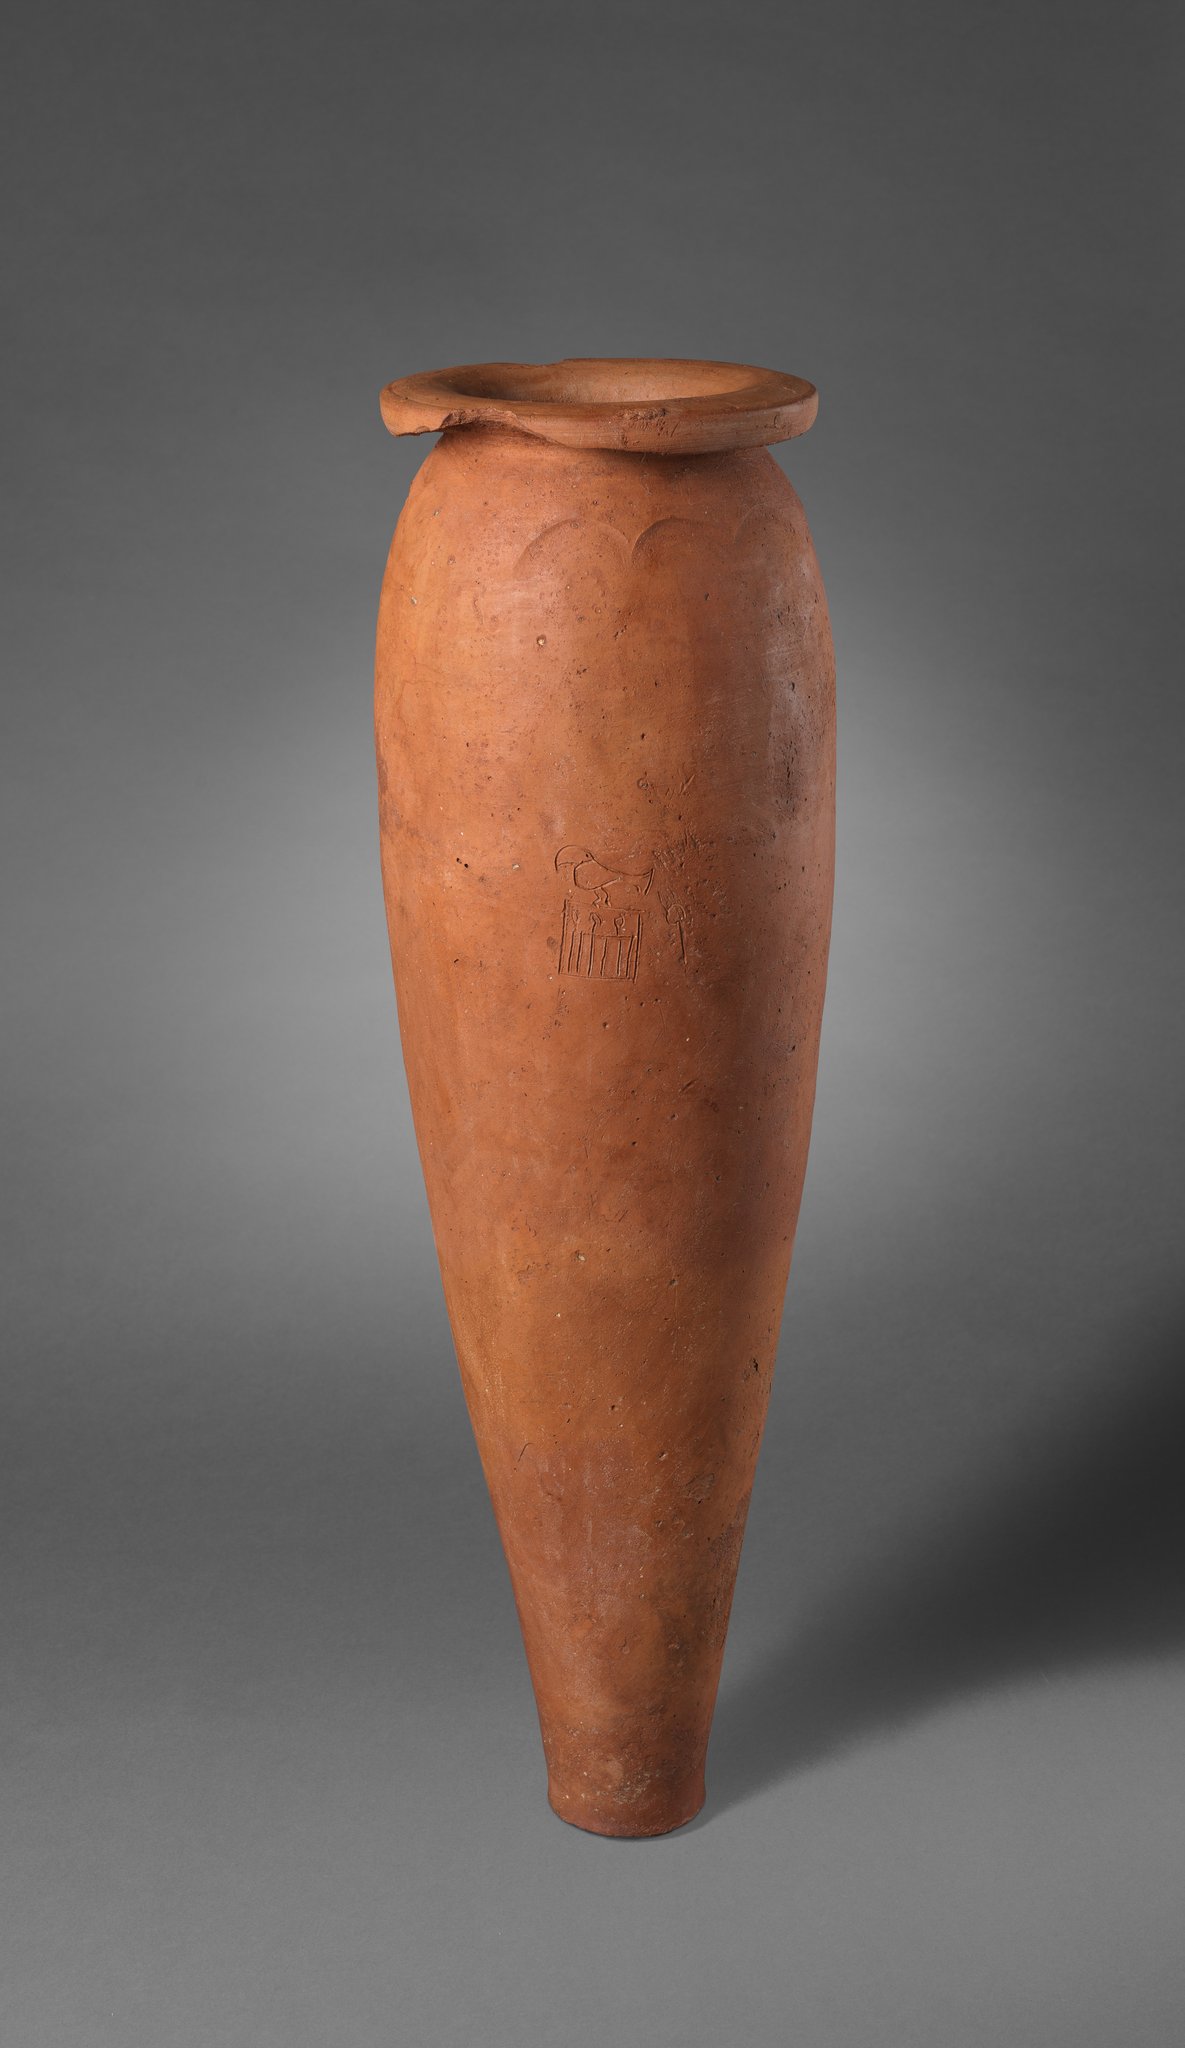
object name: jar, wine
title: Wine jar with early serekh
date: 3300-2960 BCE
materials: pottery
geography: egypt